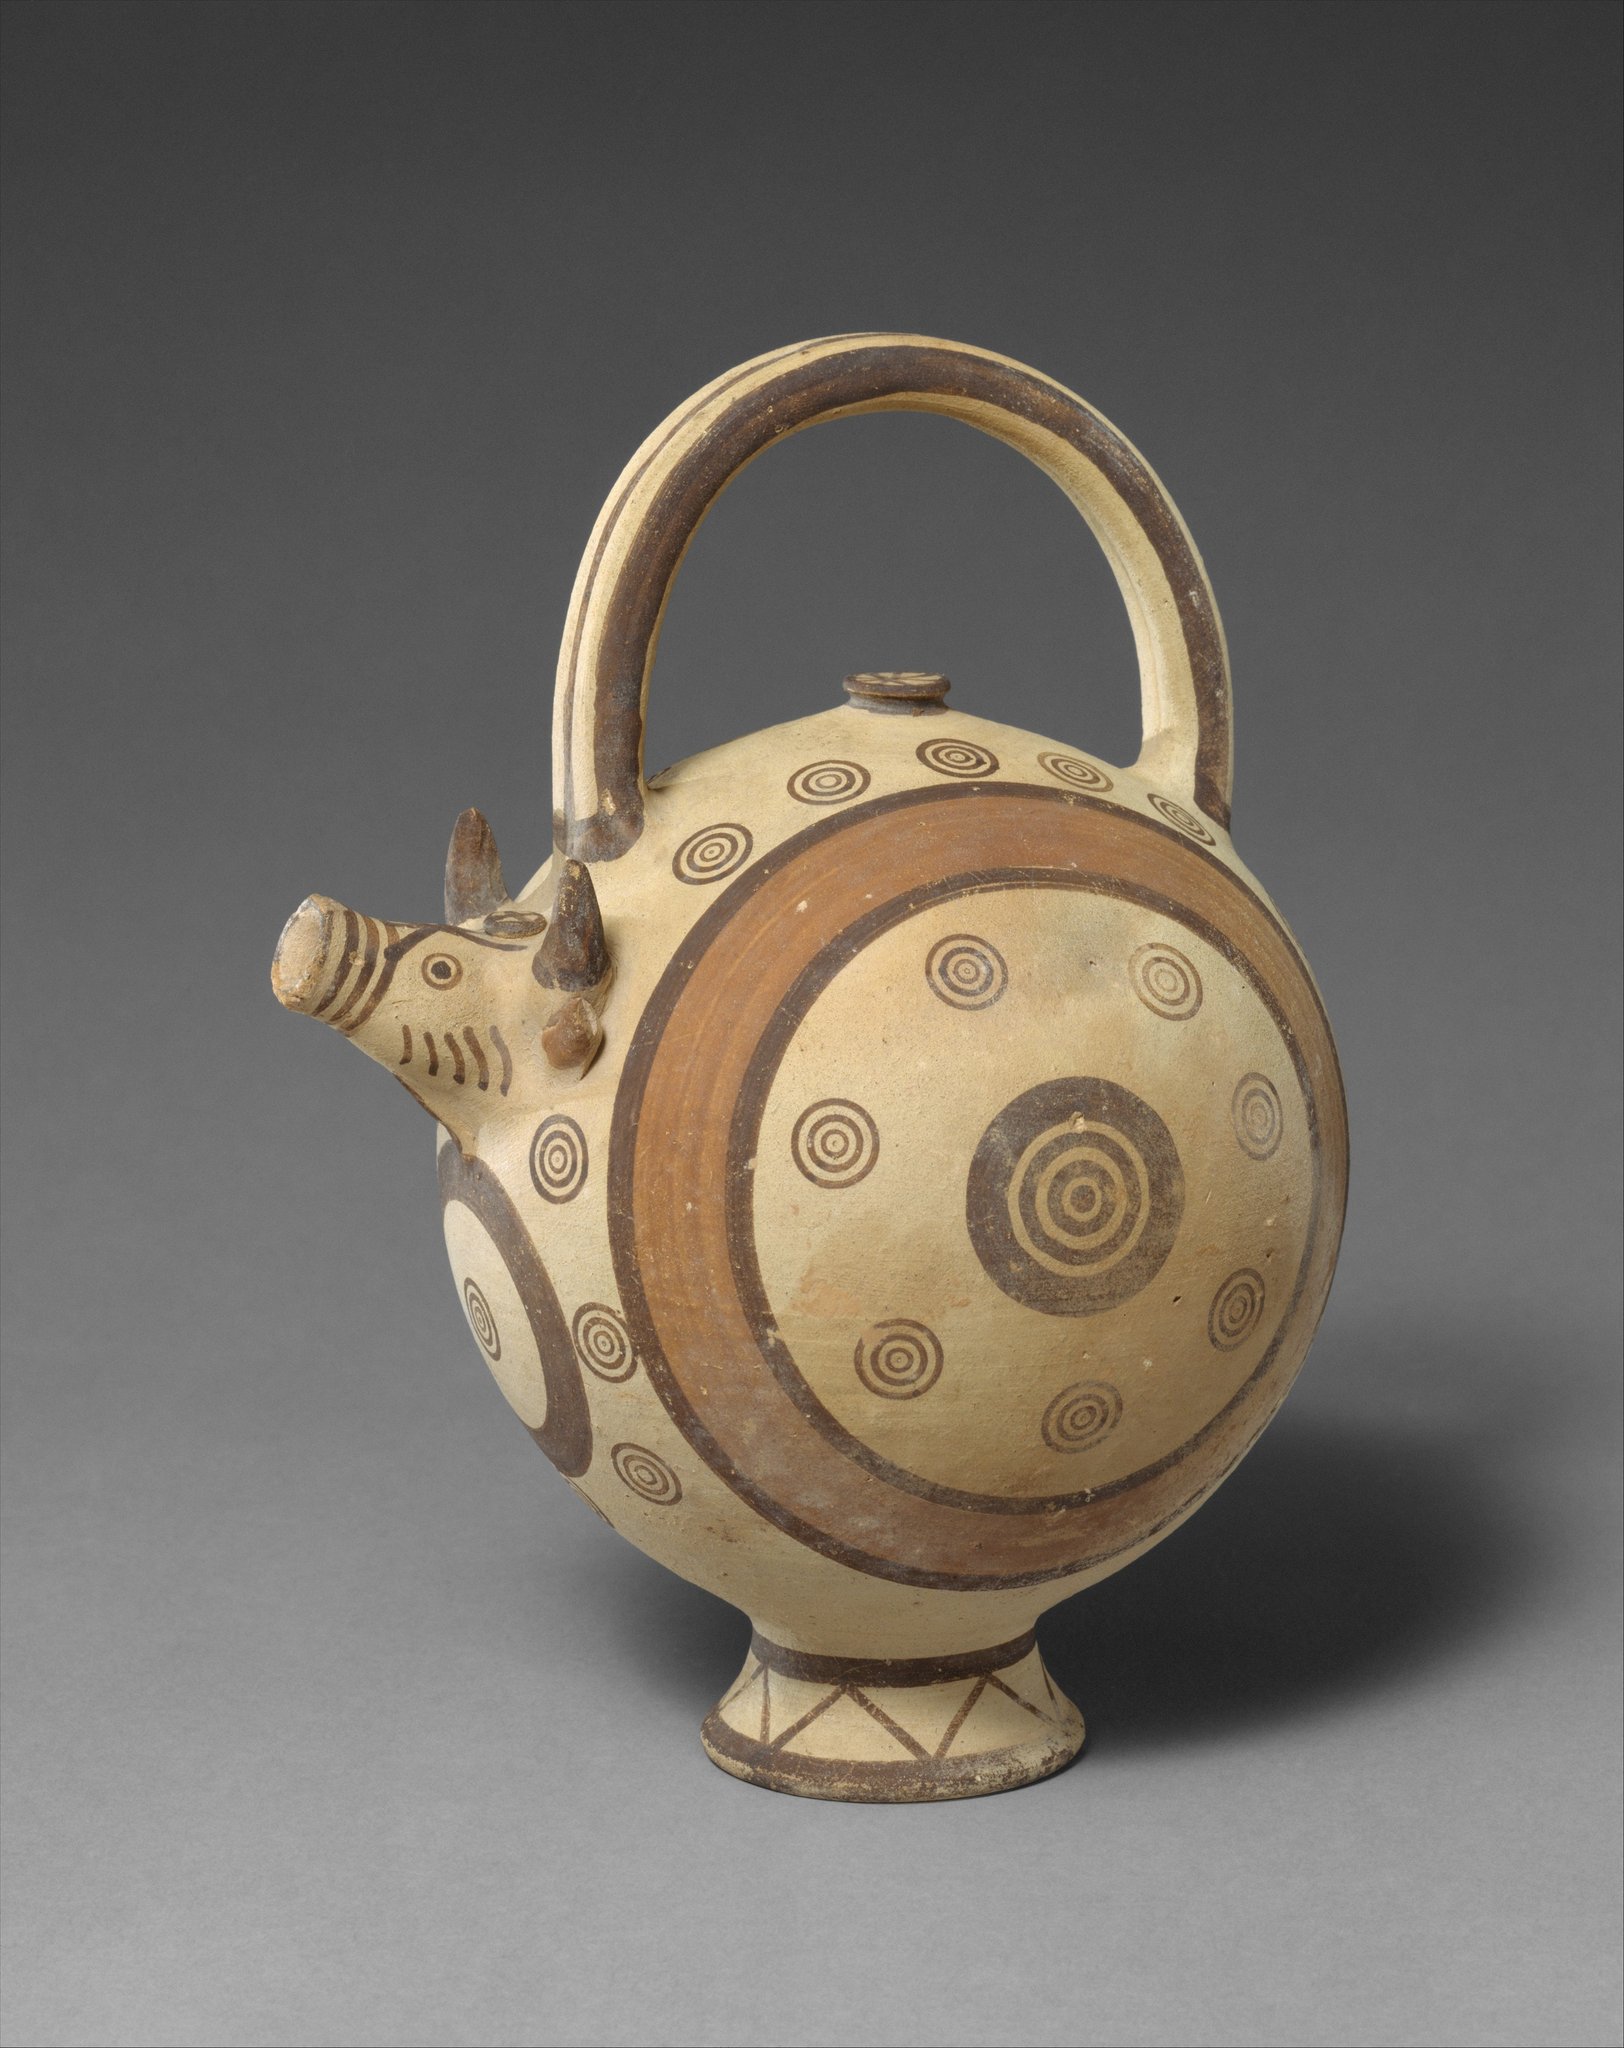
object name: trick vase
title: Terracotta trick vase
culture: cypriot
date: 750-600 BCE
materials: terracotta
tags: animals